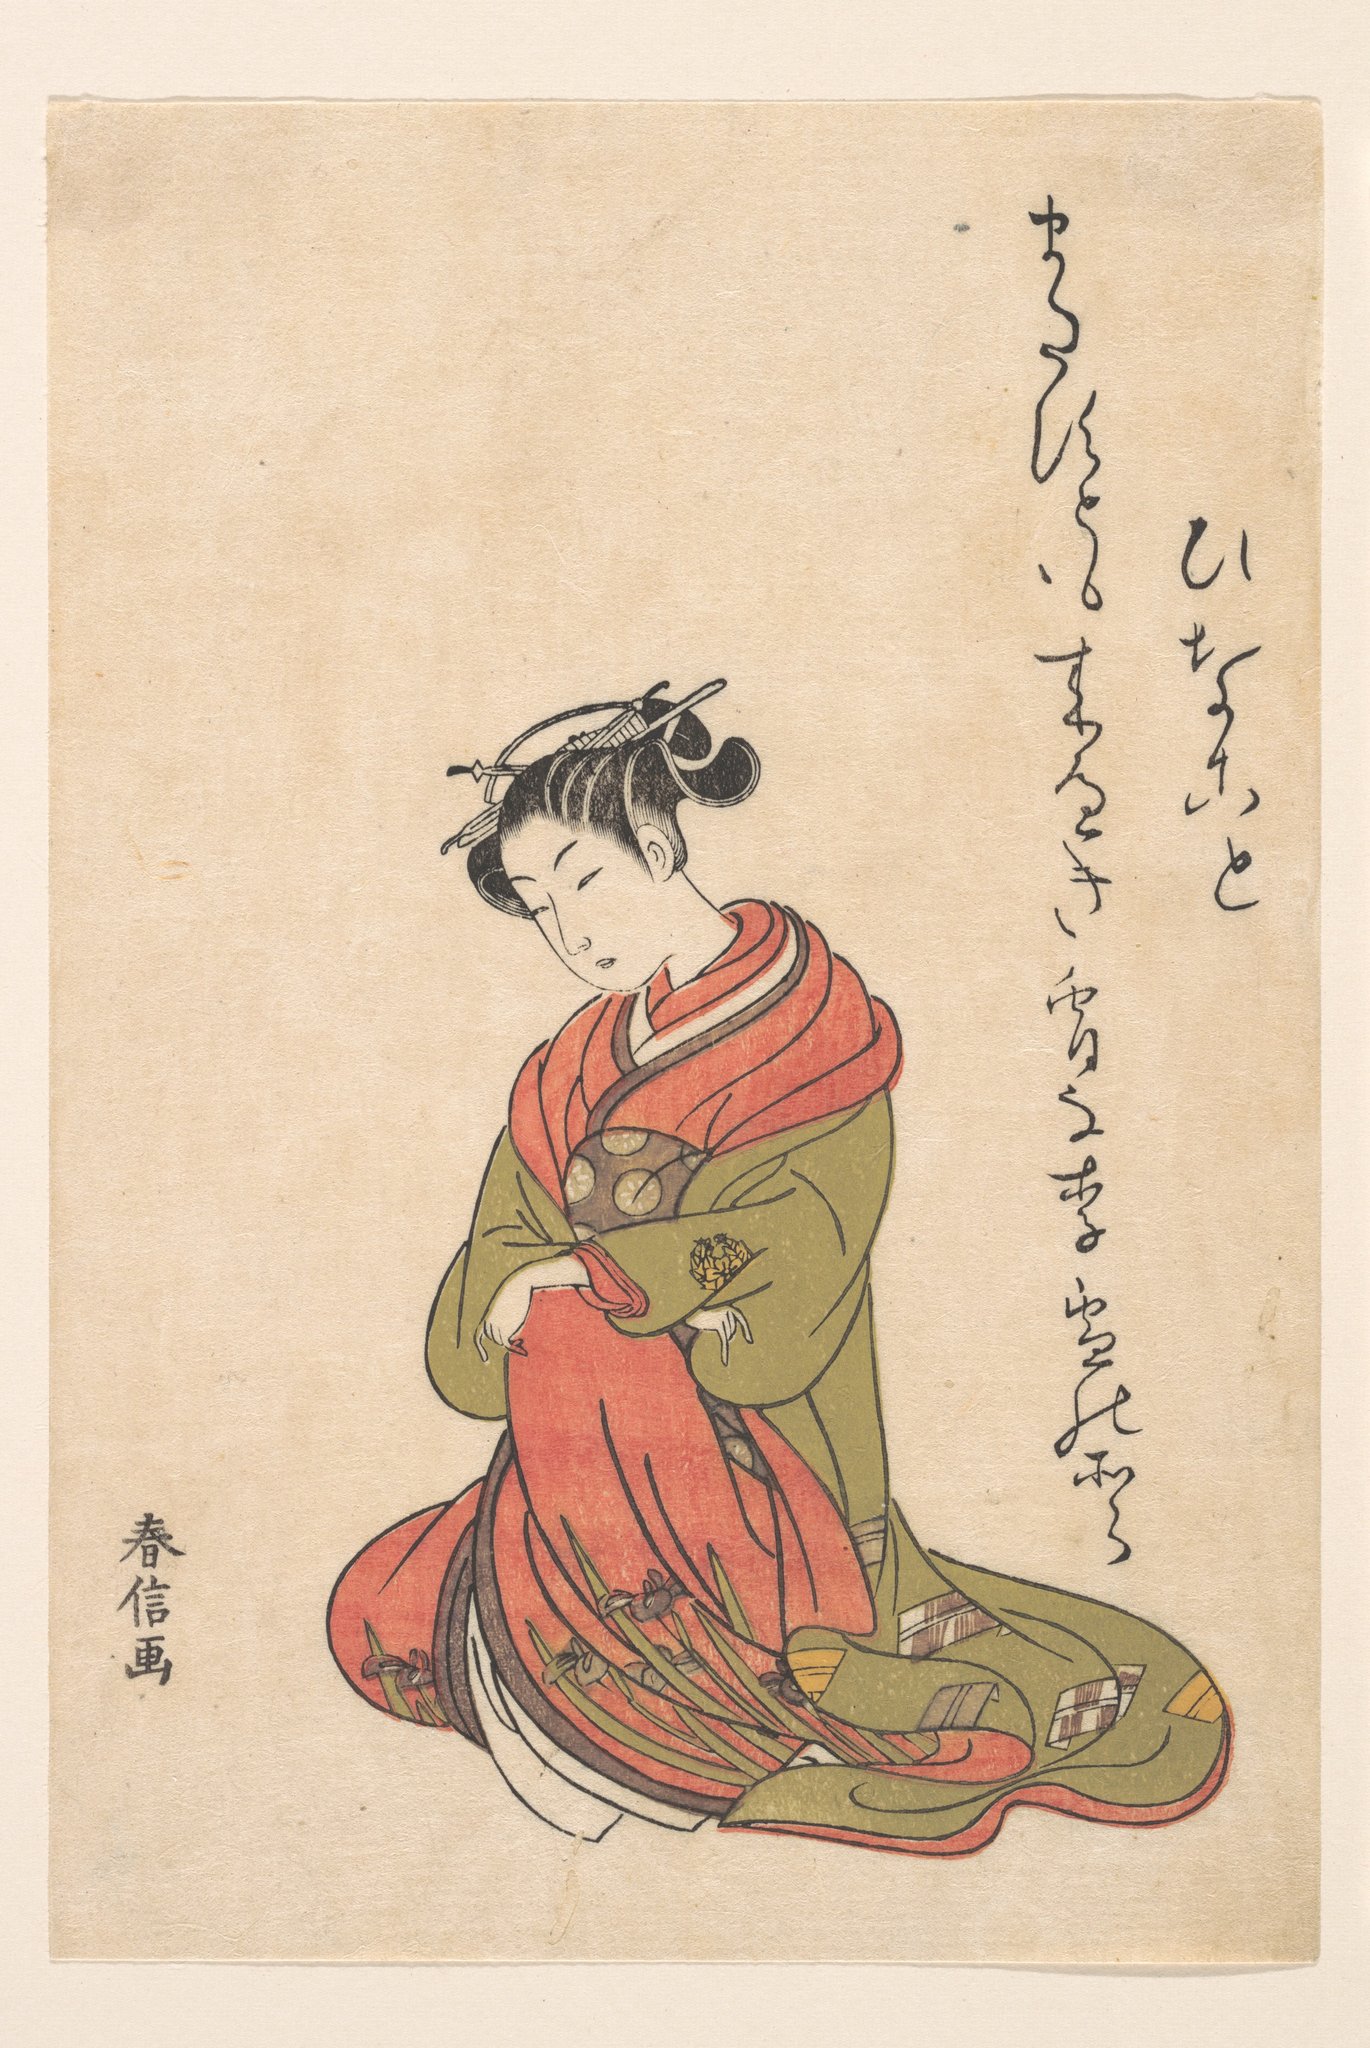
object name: print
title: The Courtesan Itsuhata with Her Pipe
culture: japanese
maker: suzuki harunobu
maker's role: artist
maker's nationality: japanese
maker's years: 1725-1770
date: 1765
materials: ink, paper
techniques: woodblock print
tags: women